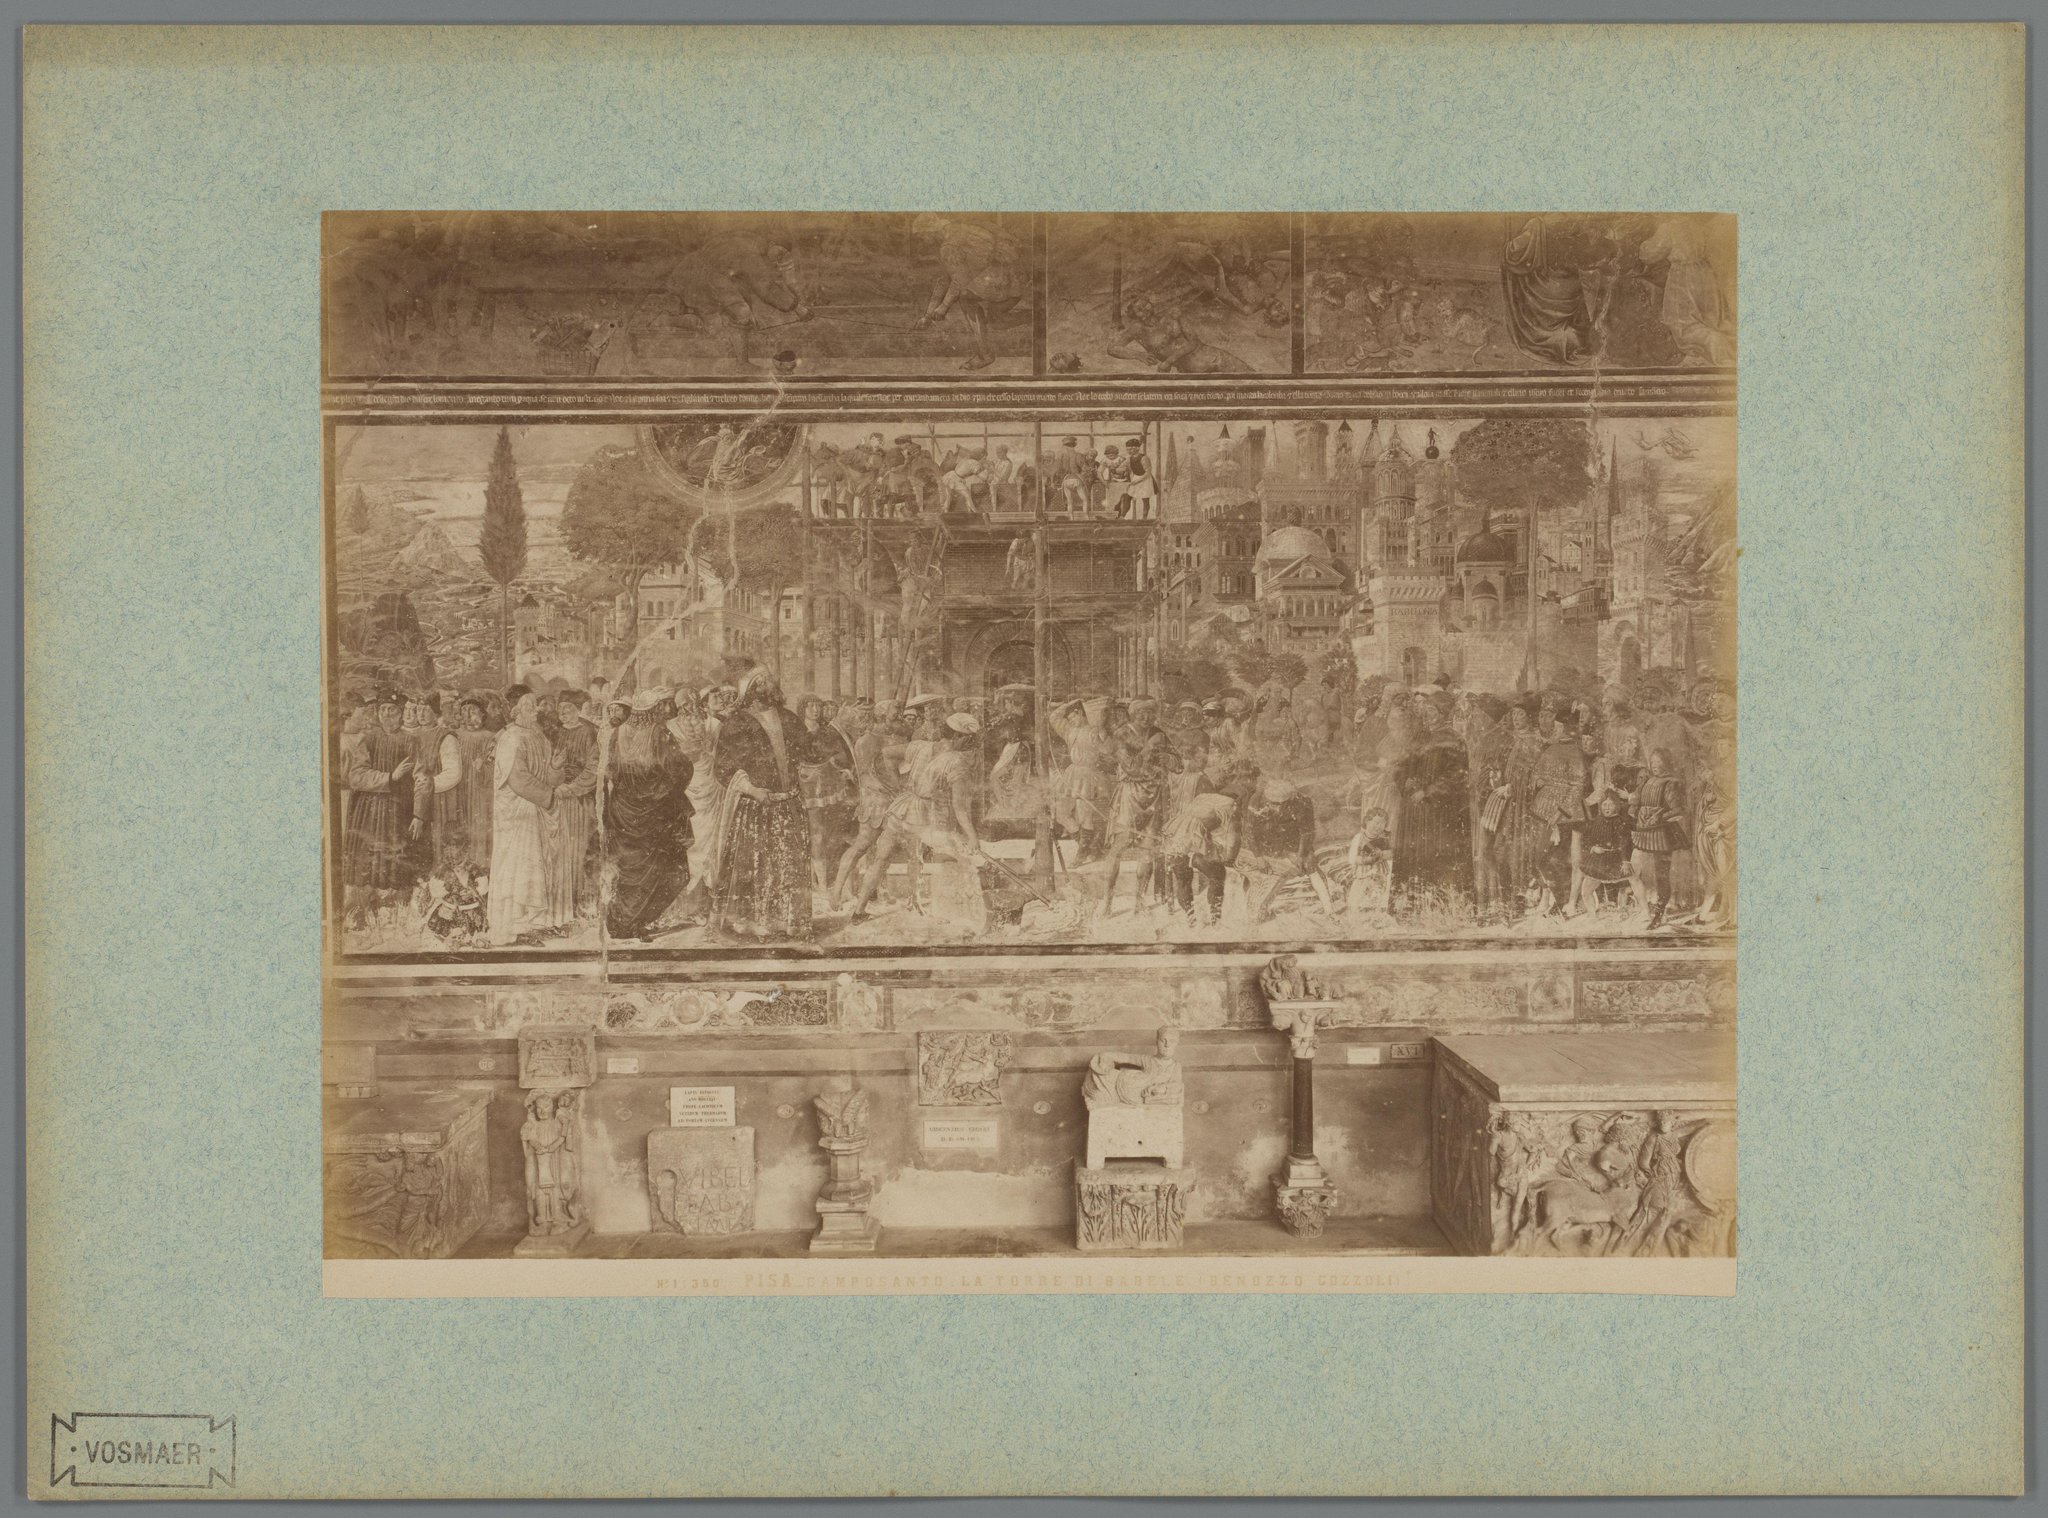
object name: reproduction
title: Pisa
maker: benozzo gozzoli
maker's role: draughtsman, painter, sculptor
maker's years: 1421-1497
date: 1852-1900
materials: cardboard, paper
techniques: albumen print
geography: pisa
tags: the building of the tower of babel; nimrod may be present, supervising or assisting the construction, wall-covering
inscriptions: number: ‘No. 11350’, collector's mark: ‘VOSMAER’